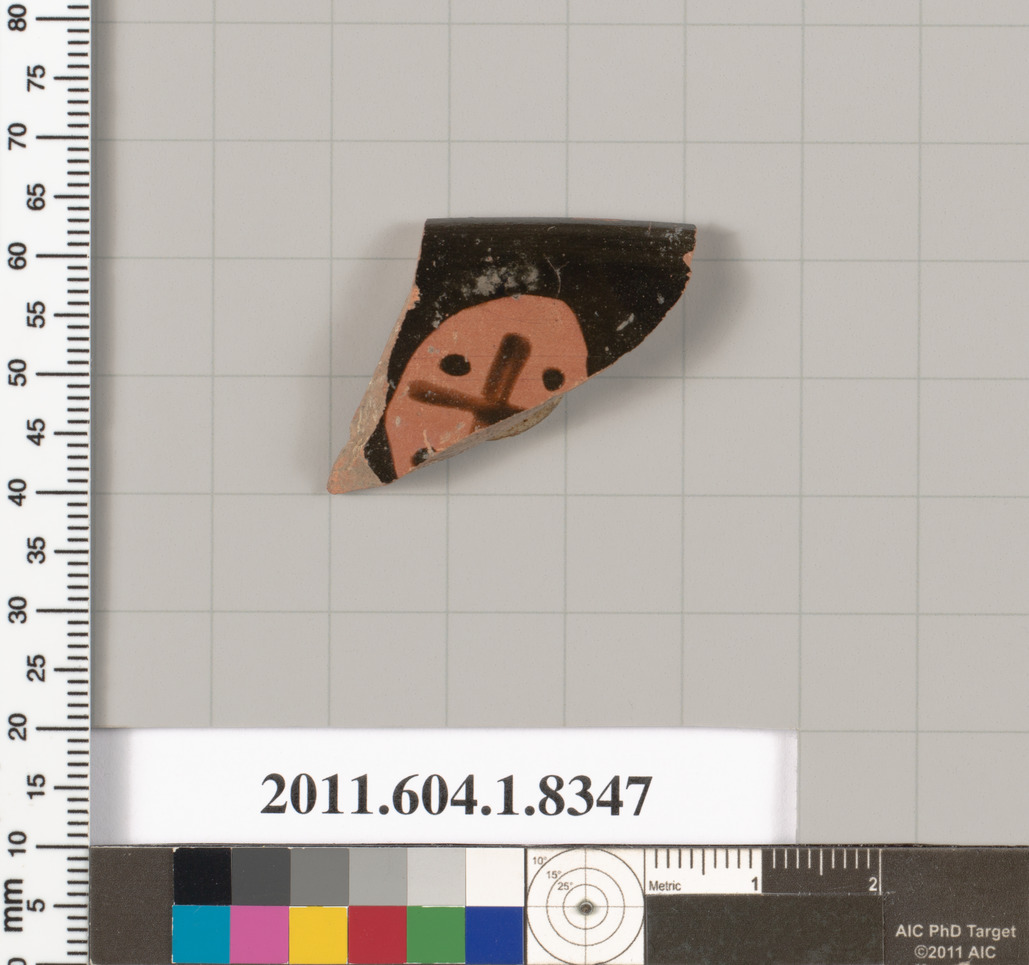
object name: kylix fragment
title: Terracotta rim fragment of a kylix (drinking cup)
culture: greek, attic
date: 400-376 BCE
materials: terracotta